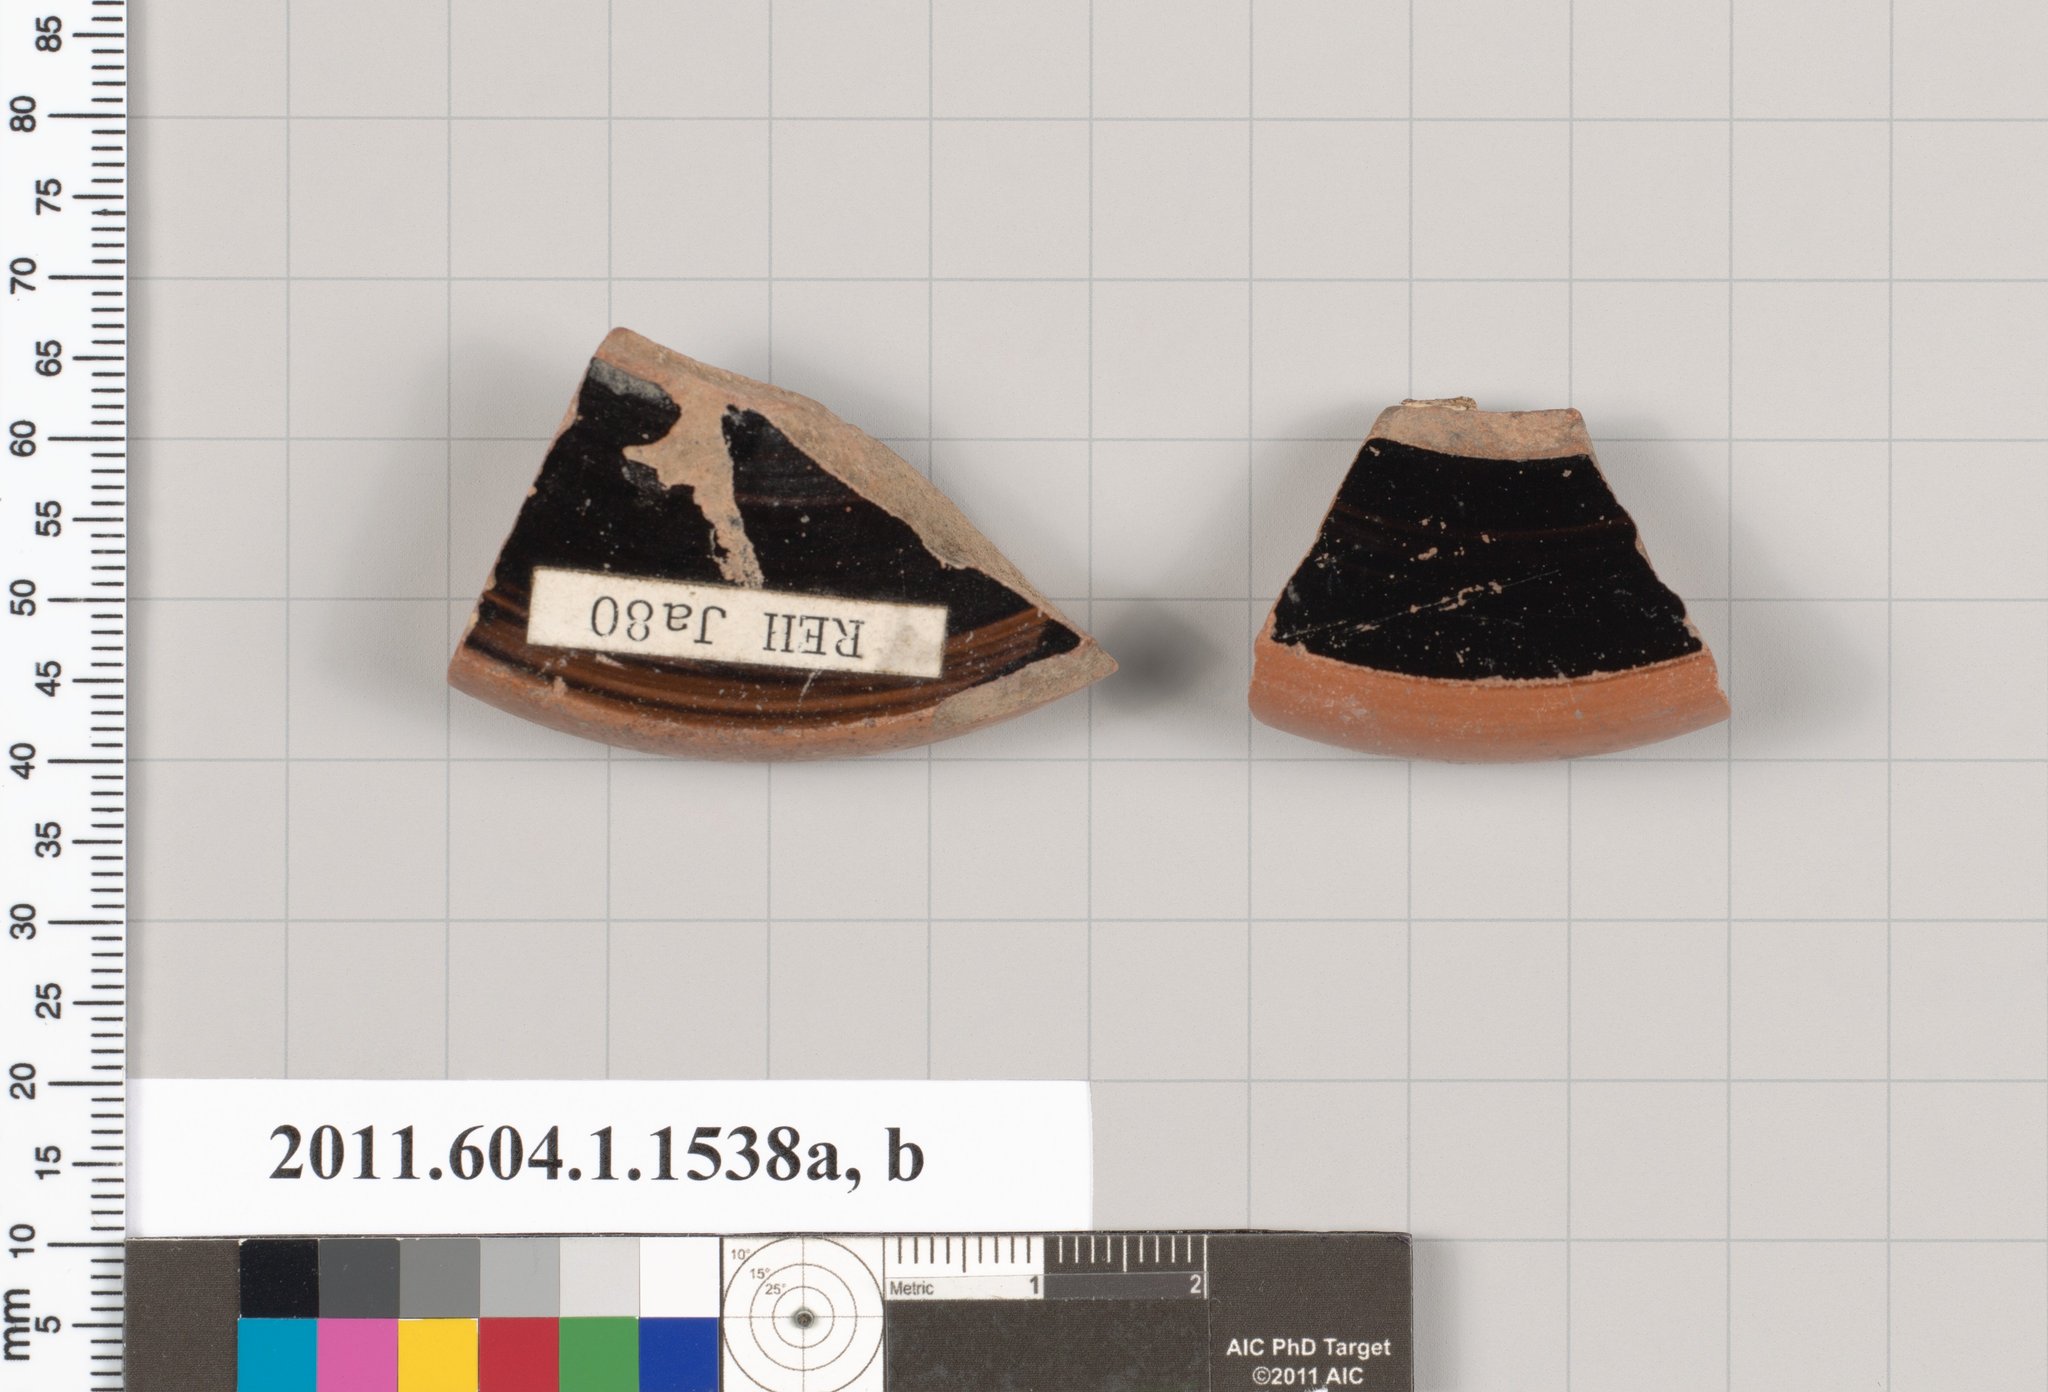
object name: kylix fragment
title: Terracotta fragments of kylikes (drinking cups)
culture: greek, attic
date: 500-401 BCE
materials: terracotta